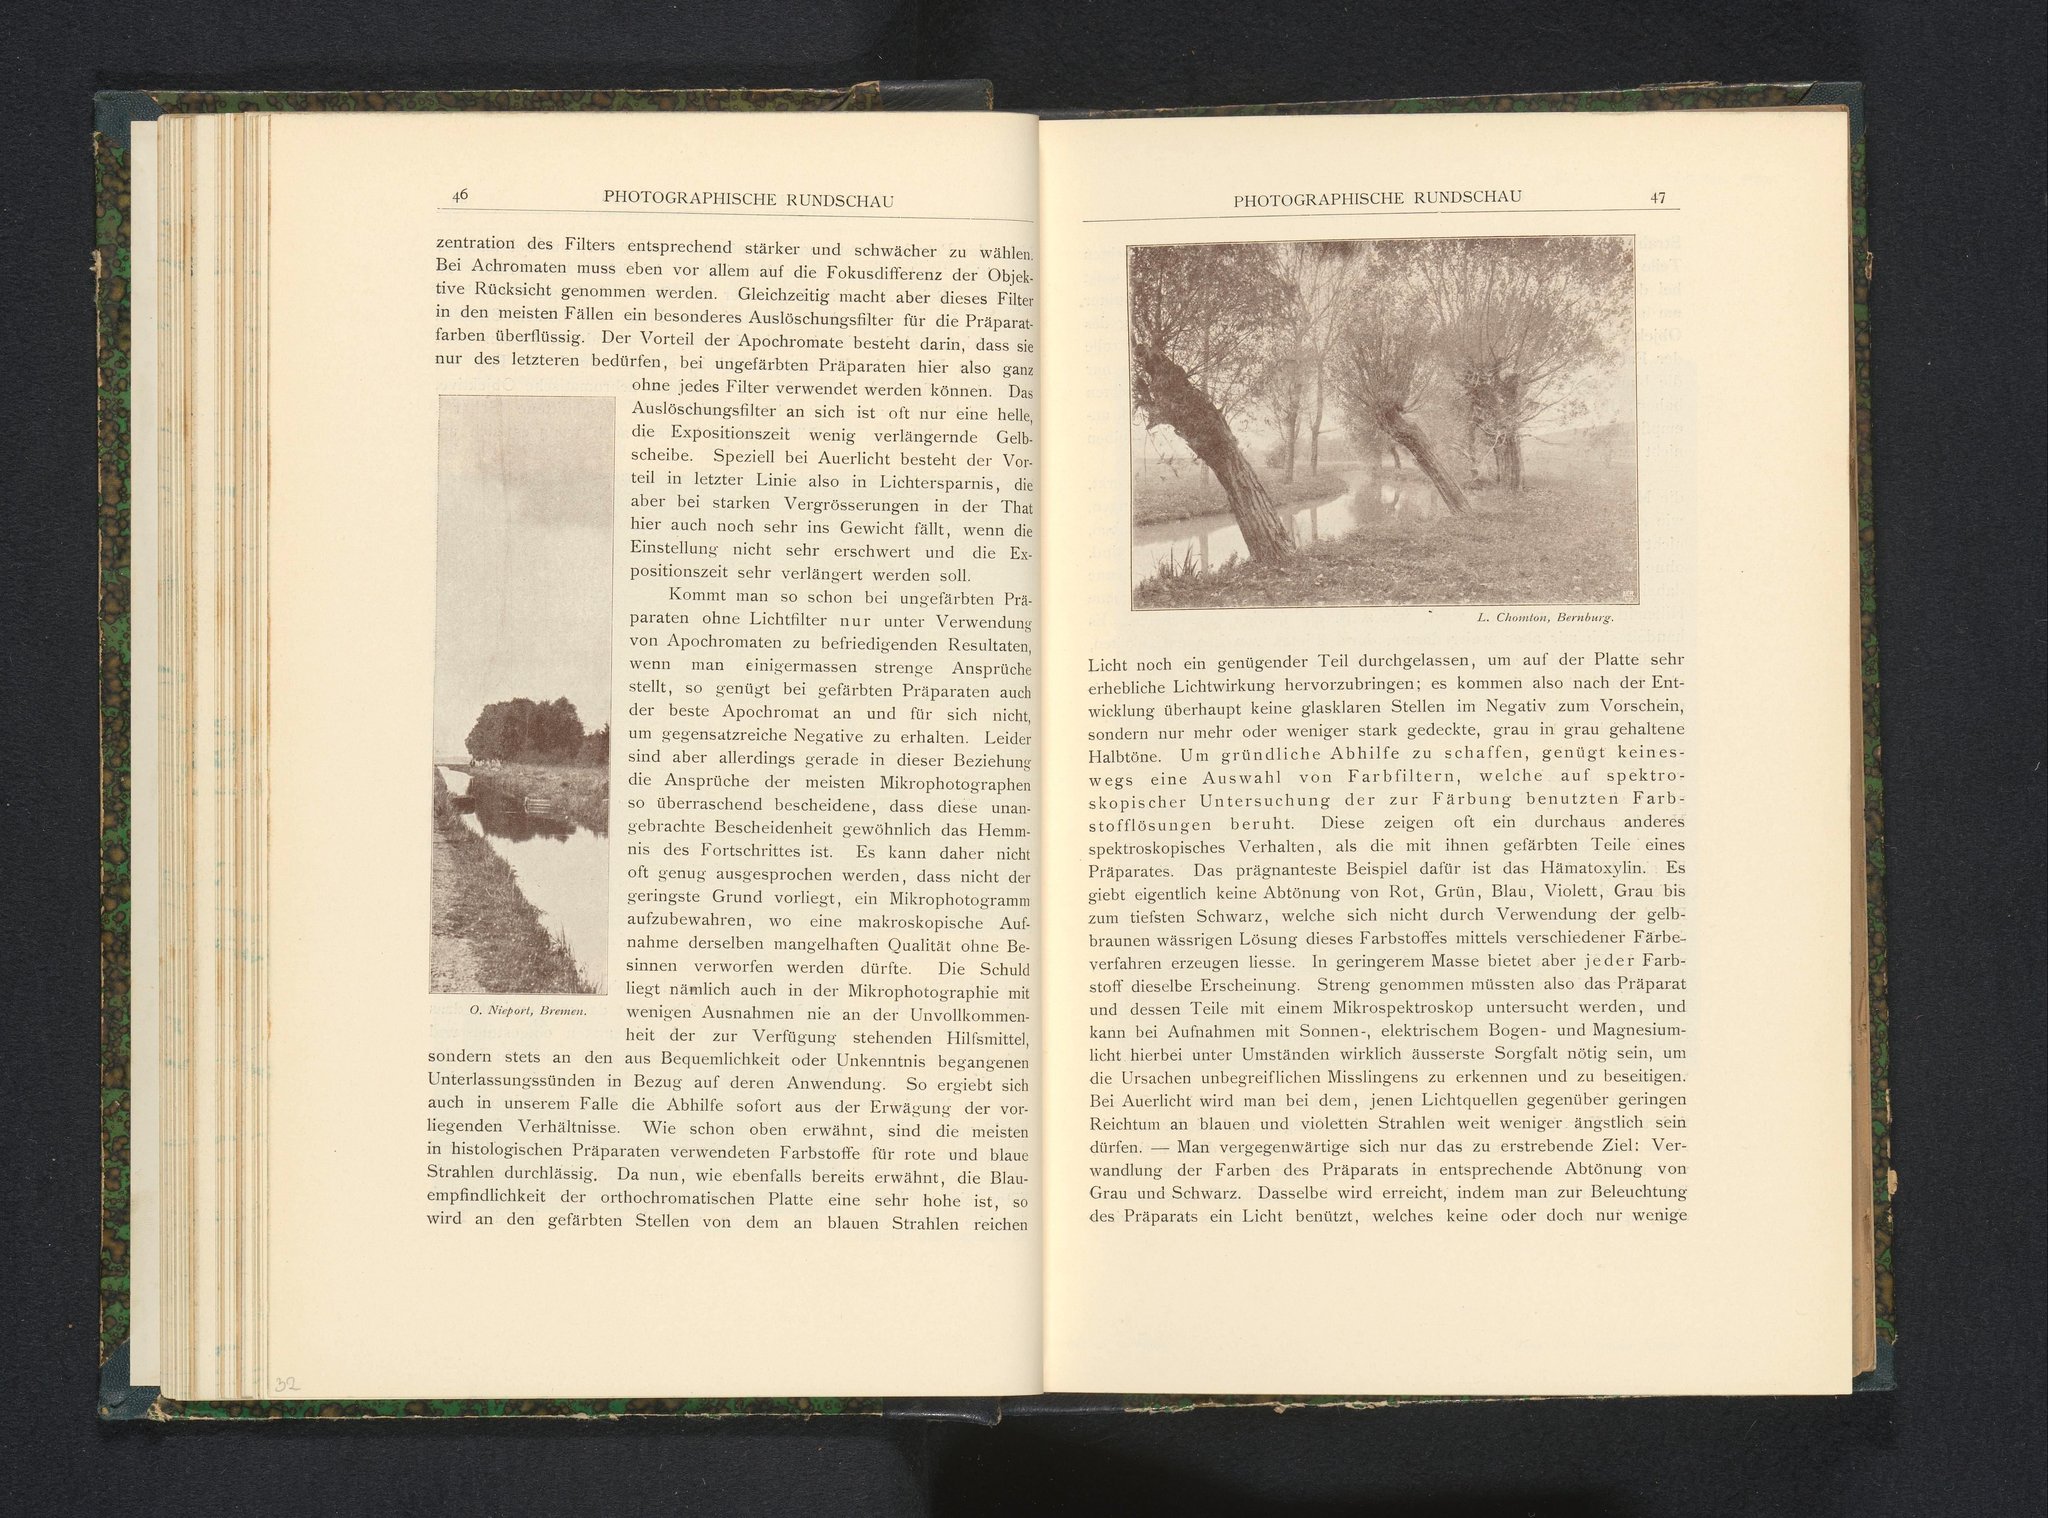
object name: page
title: Bomen langs een sloot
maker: l. chomton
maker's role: fotograaf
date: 1894-1899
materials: paper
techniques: autotype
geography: berlin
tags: landscapes, small canal, ditch